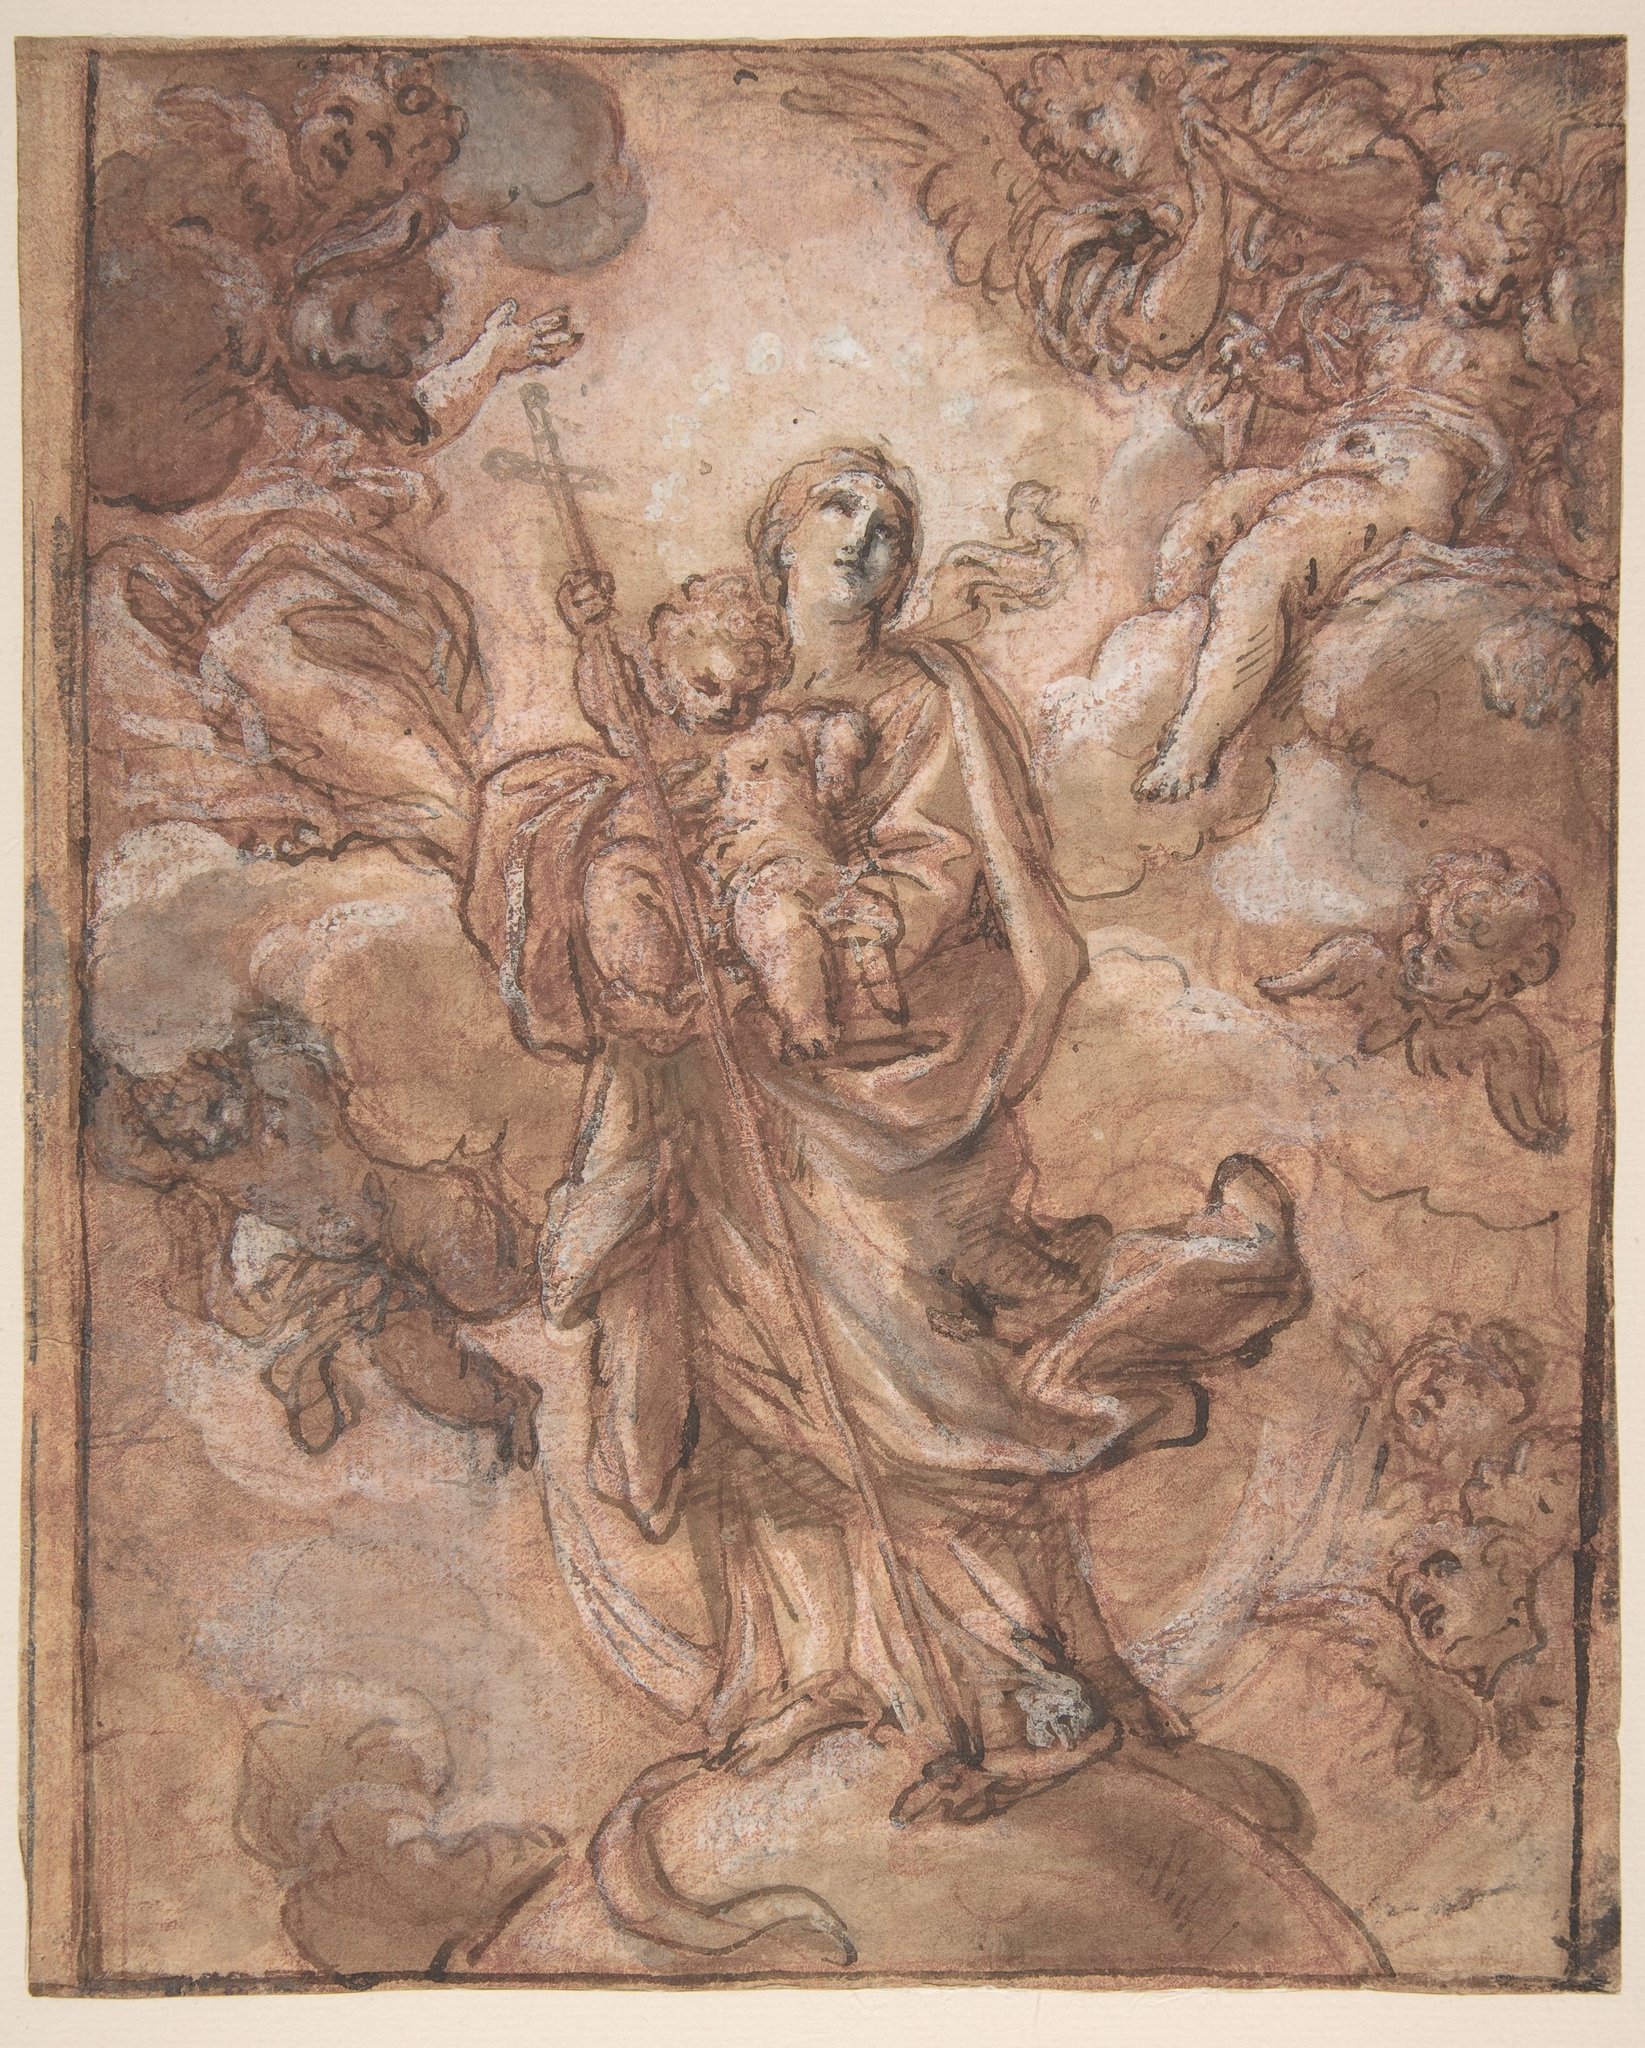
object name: drawing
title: The Virgin Immaculate with the Christ Child in Glory (recto); Rinaldo and Armida (verso)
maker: giuseppe passeri (passari)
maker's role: artist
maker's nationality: italian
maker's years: 1654-1714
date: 1654-1714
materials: chalk, ink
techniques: brush, highlighting, pen, wash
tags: angels,madonna and child